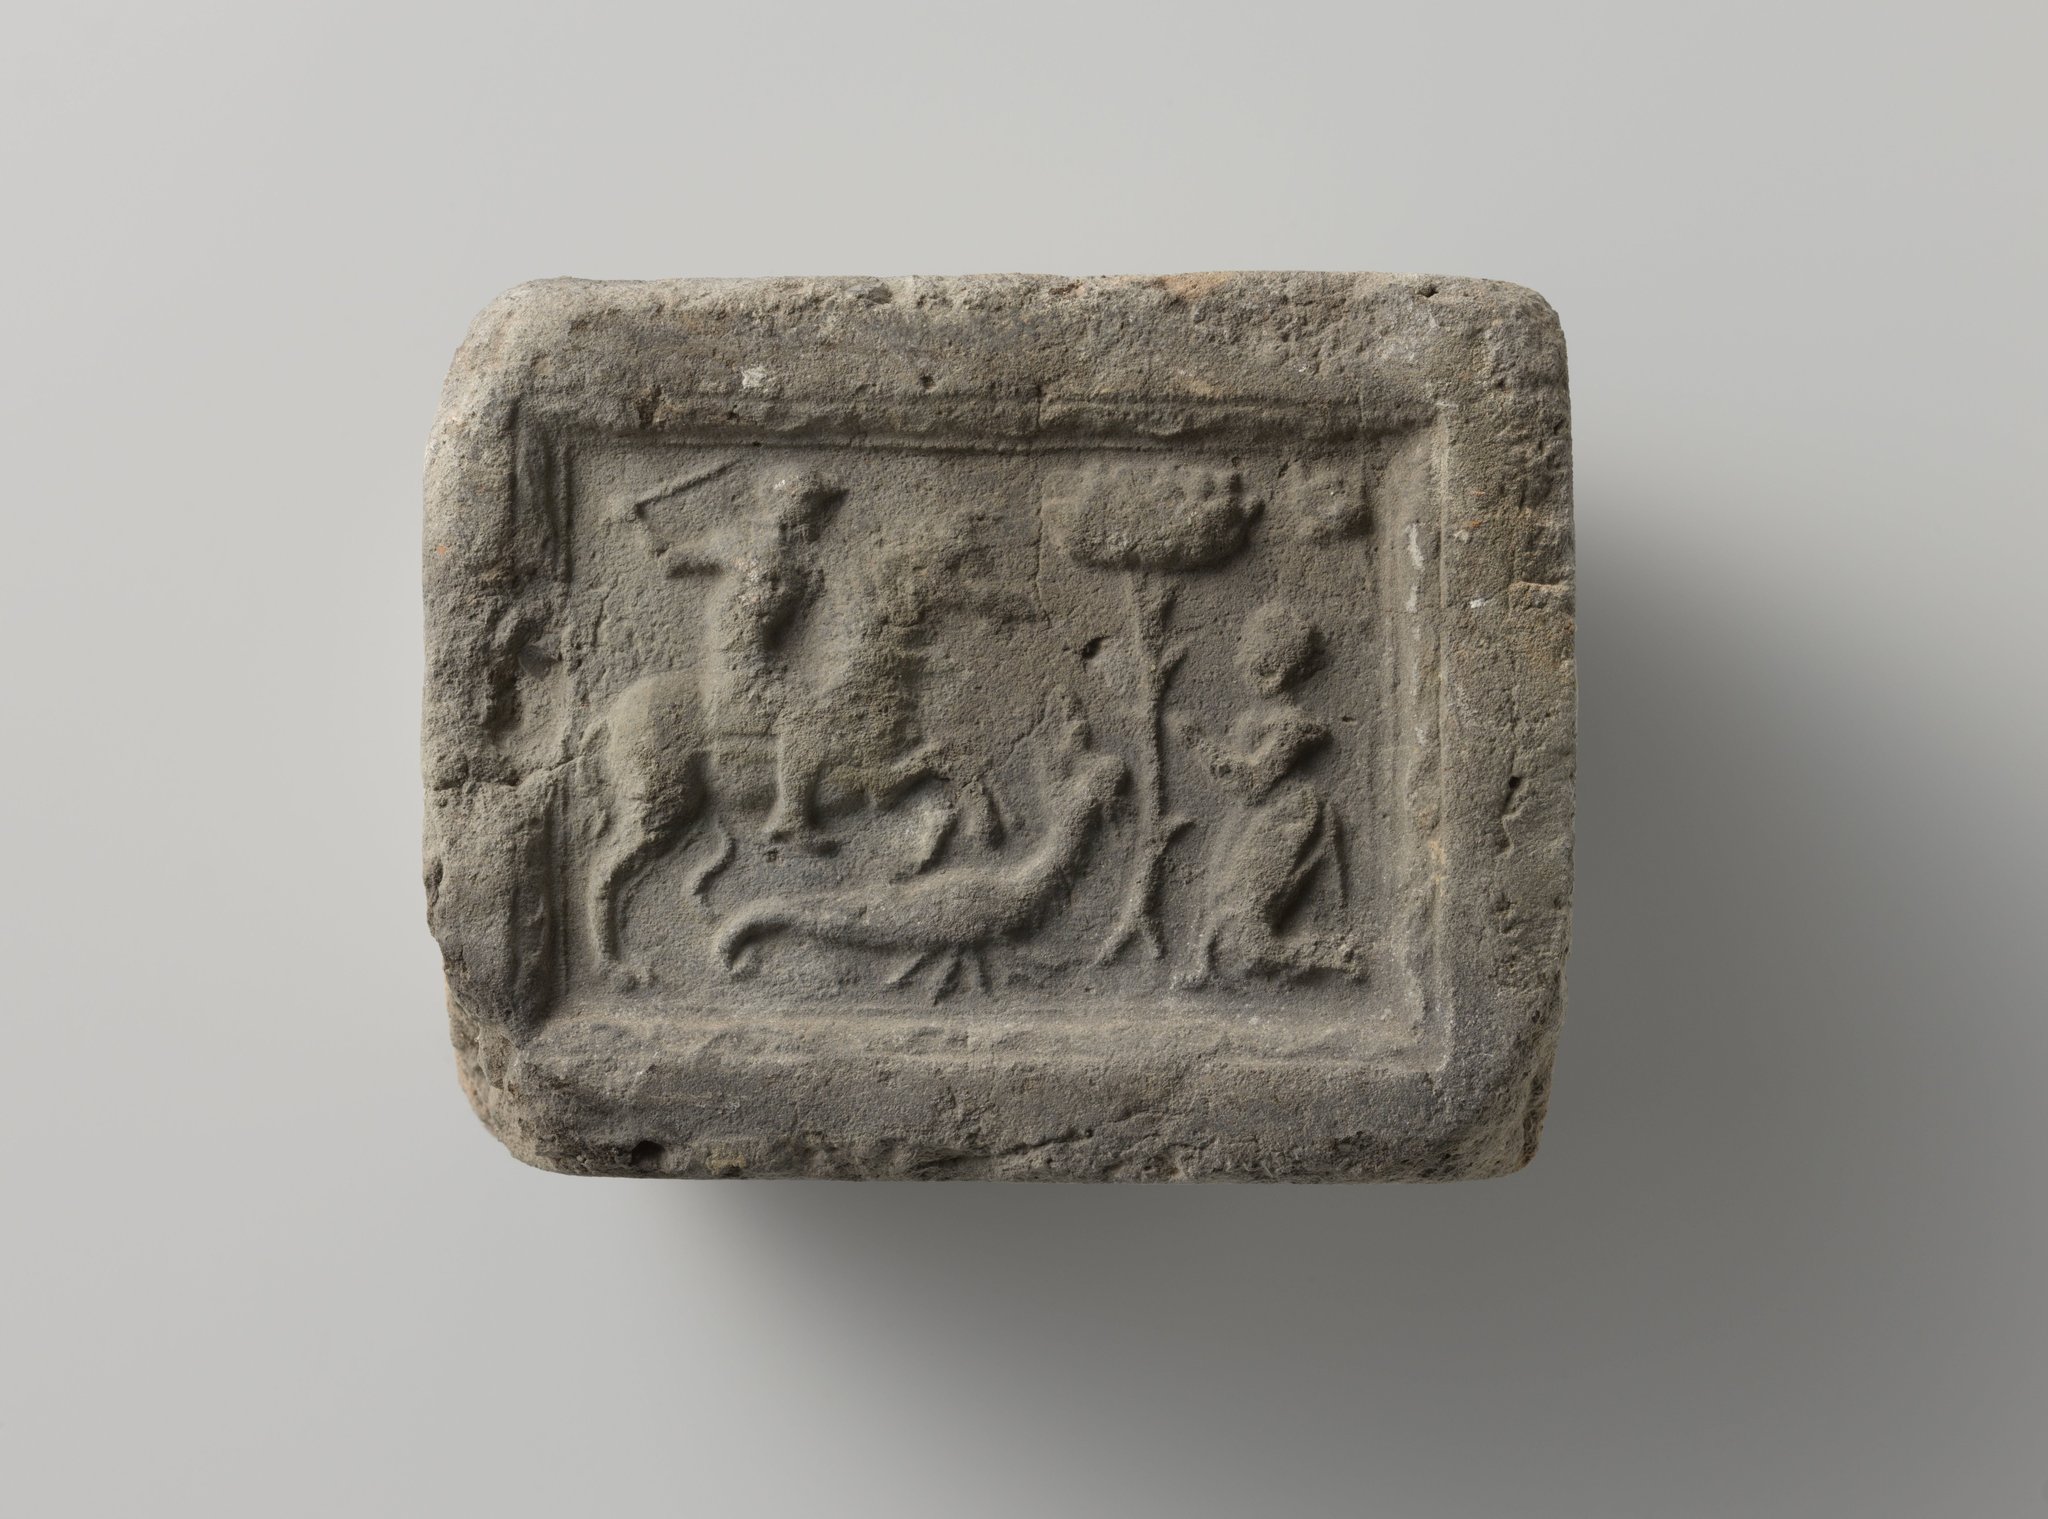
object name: architectural element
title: Haardsteen, waarop Andromeda of Sint Joris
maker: Anonymous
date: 1400-1950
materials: earthenware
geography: southern netherlands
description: Haardsteen, waarop Andromeda of Sint Joris. Van fijne gebakken aarde. Met enige wijzigingen.